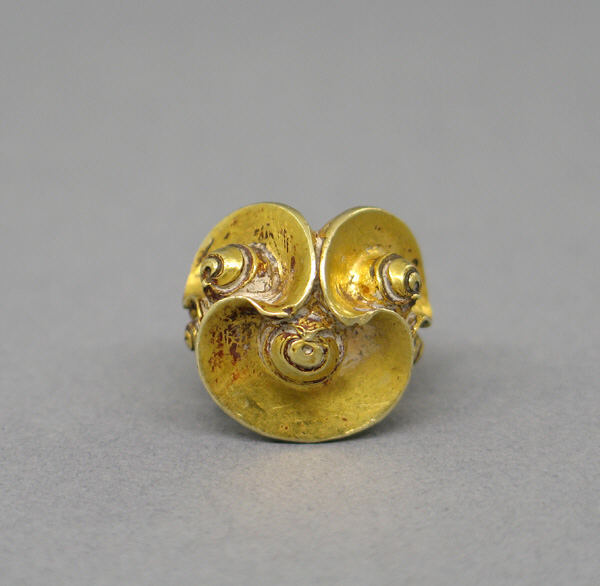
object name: ear ornament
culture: indonesian, javanese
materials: gold